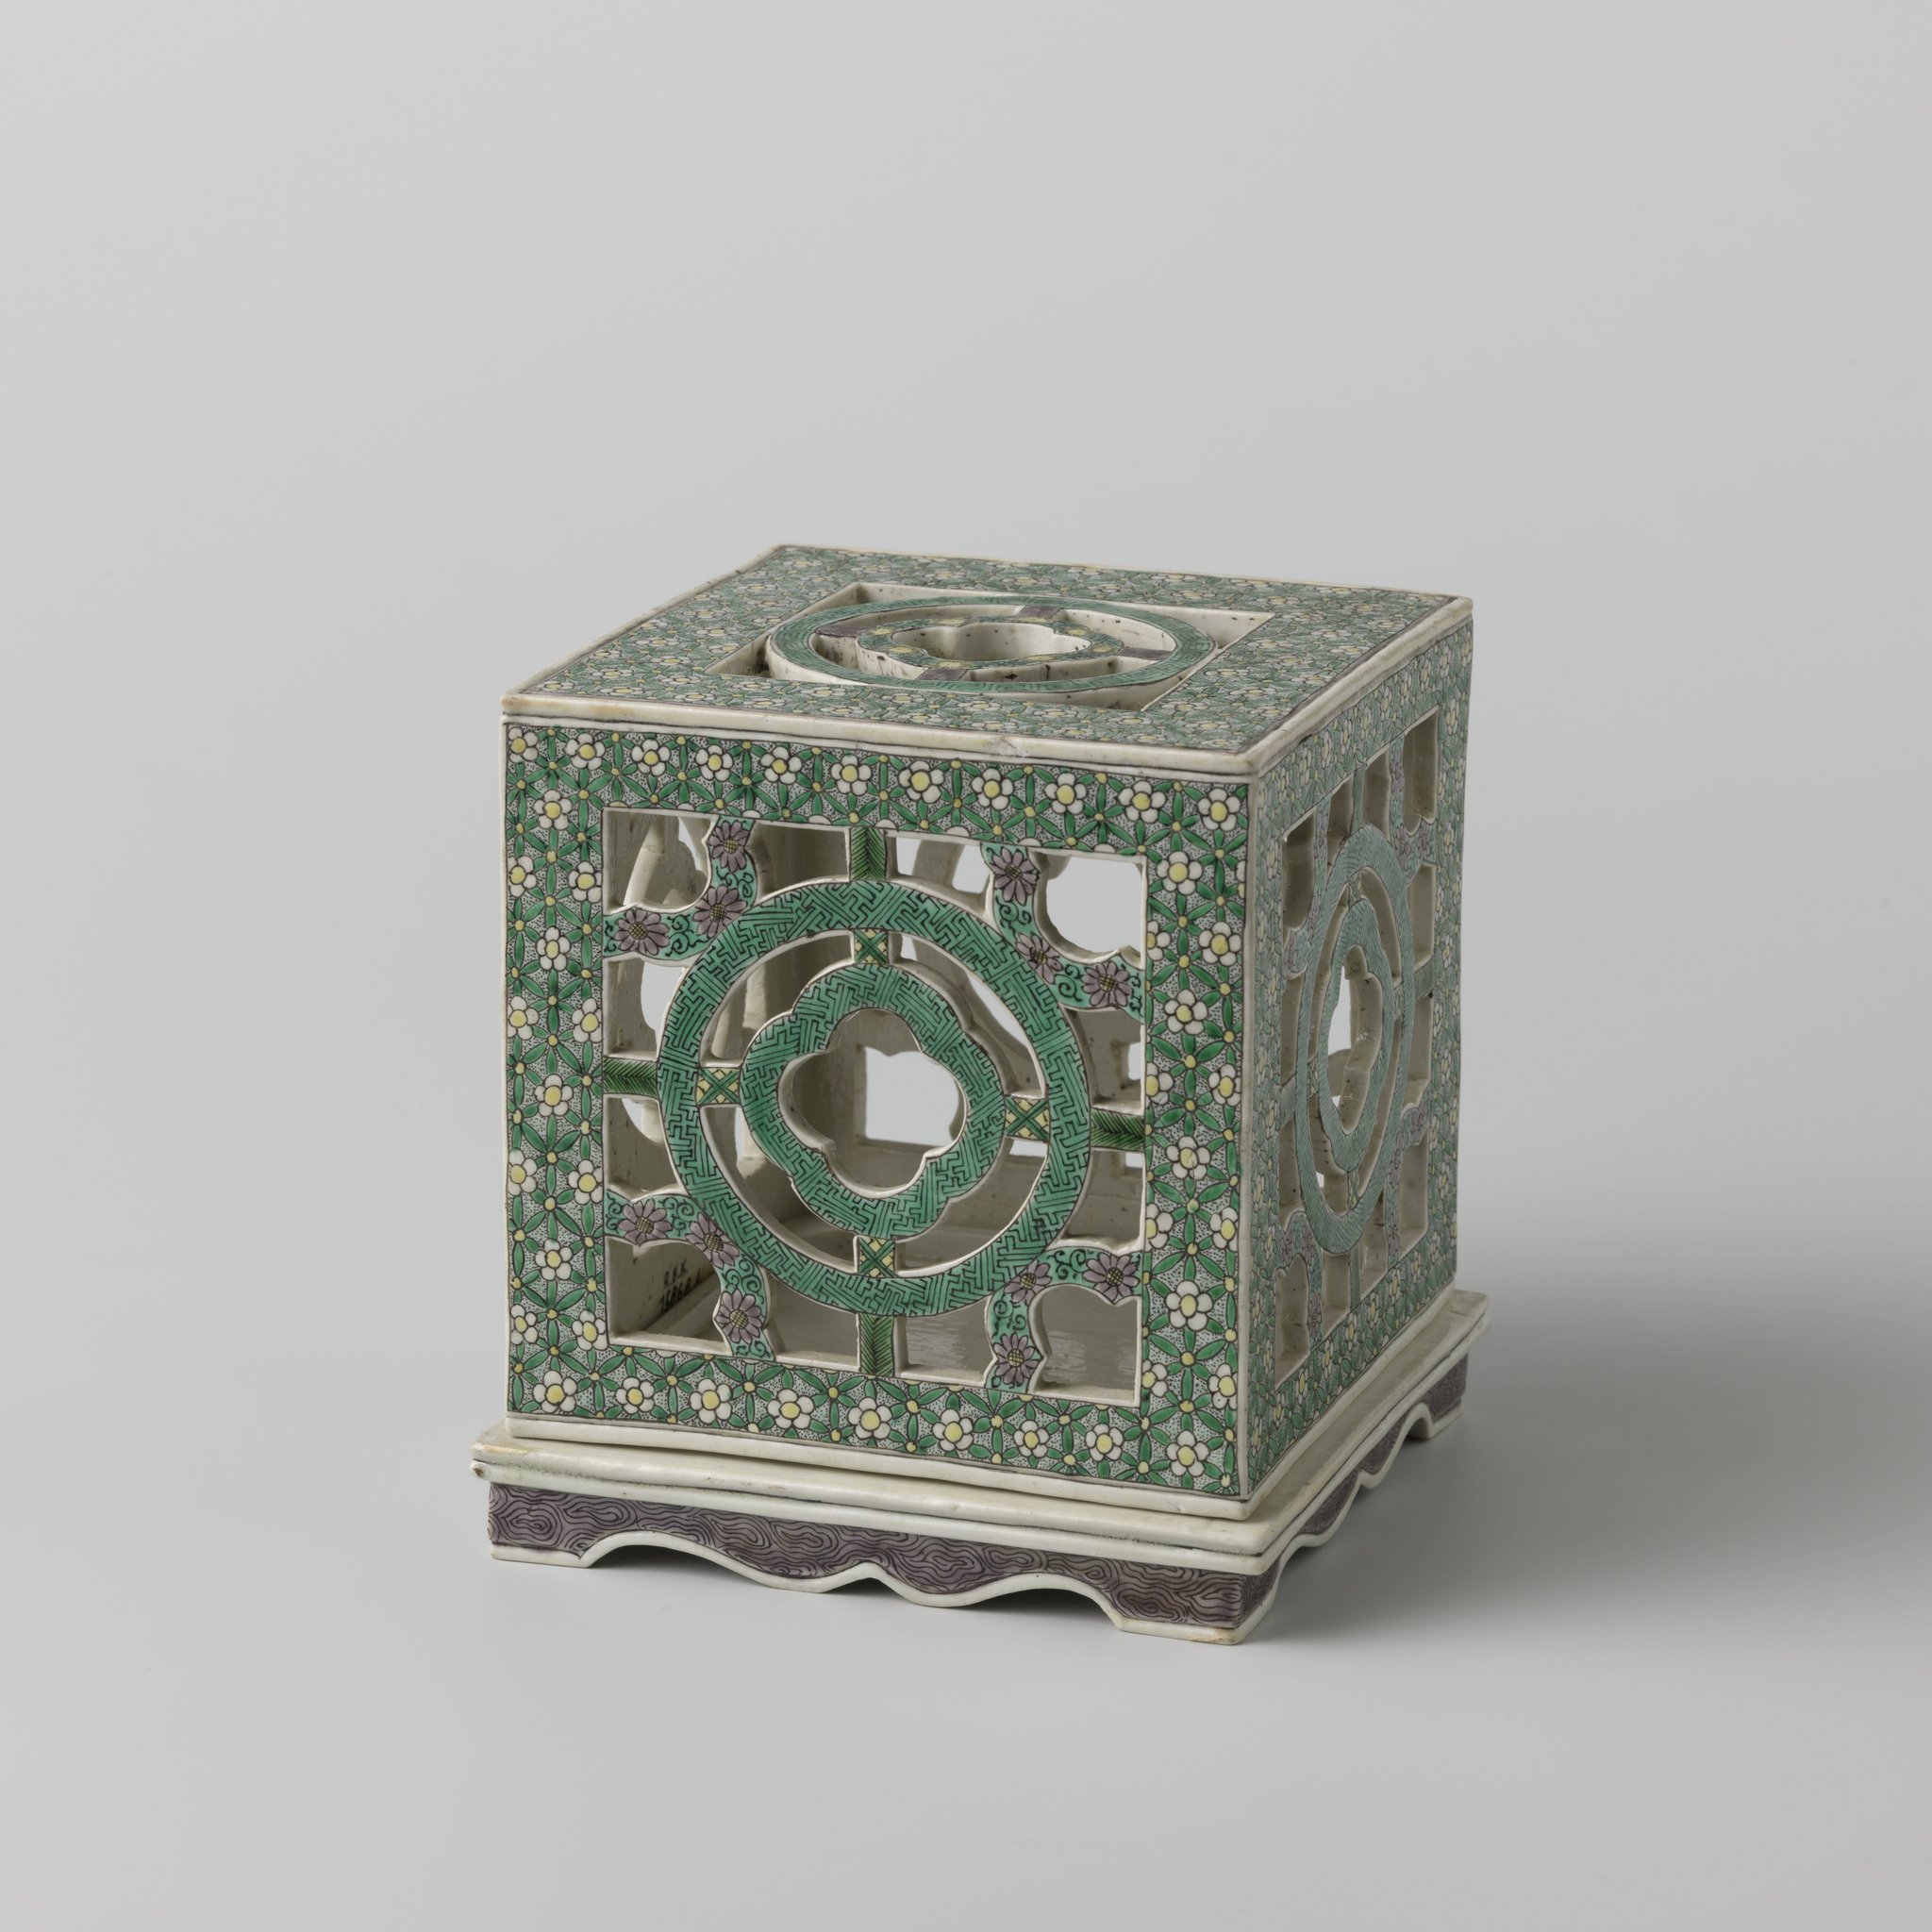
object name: foot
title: Square lantern with pierced sides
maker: Anonymous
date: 1700-1724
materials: glaze, paint, porcelain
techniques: embroidery, firing, forming, vitrification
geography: china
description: Voet van vierkante lantaarn van porselein, beschilderd op biscuit in blauw, groen, geel, aubergine en zwart. De voet met een houtnerf-patroon. Email sur biscuit met famille verte kleuren.